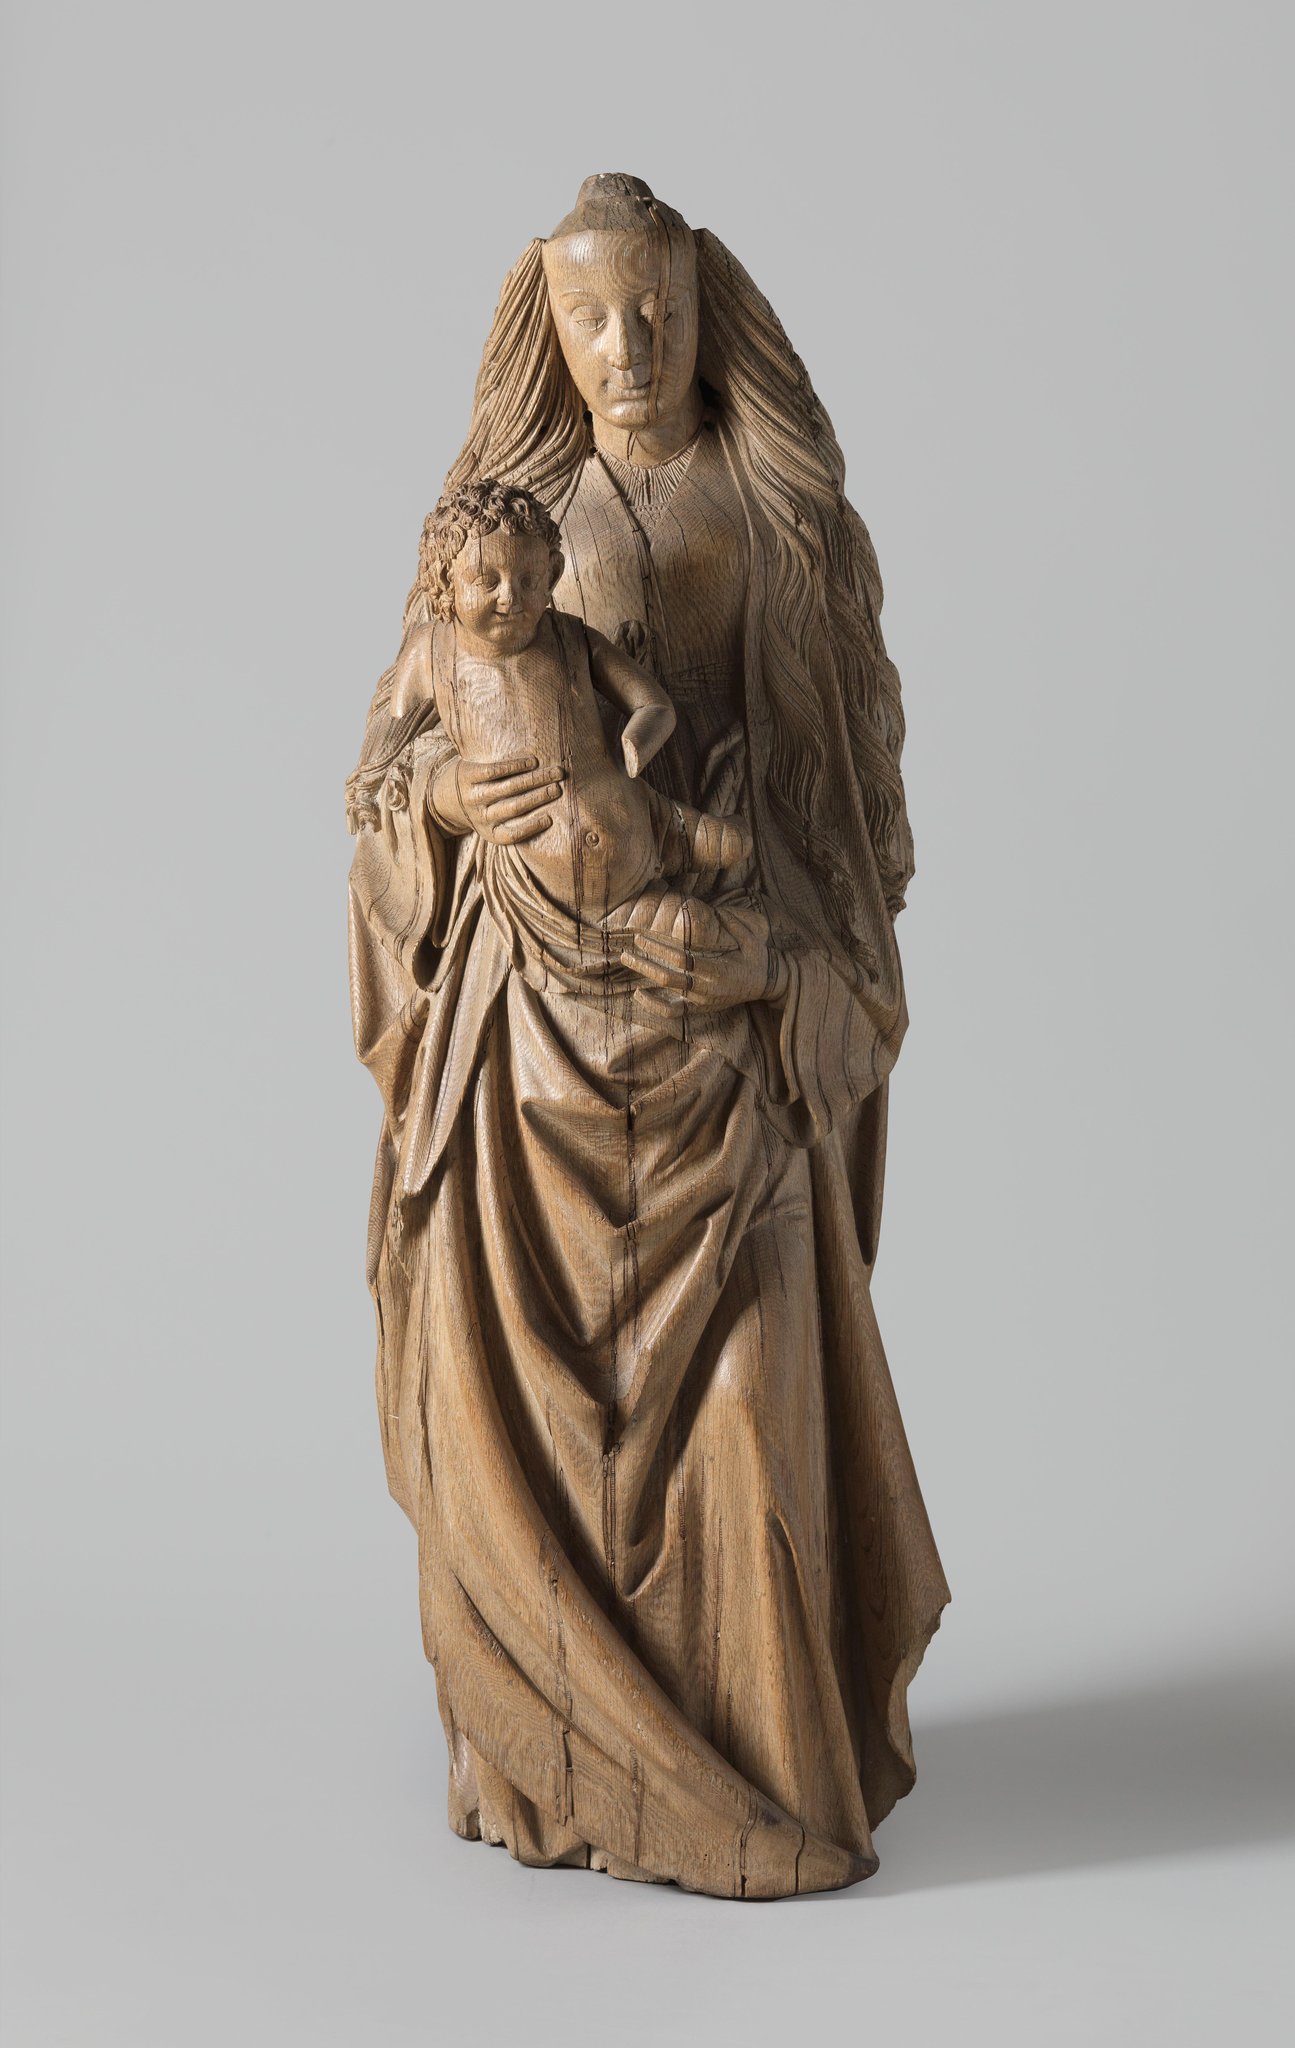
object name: sculpture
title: Virgin and Child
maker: henrik douverman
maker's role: sculptor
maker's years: 1480-1544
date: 1510-1515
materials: wood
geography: cleves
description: Master of the St Christopher of Oud-Zevenaar (active c. 1490 - c. 1510). Virgin and Child. Oak, originally with polychromy. Lower Rhine, c. 1510.